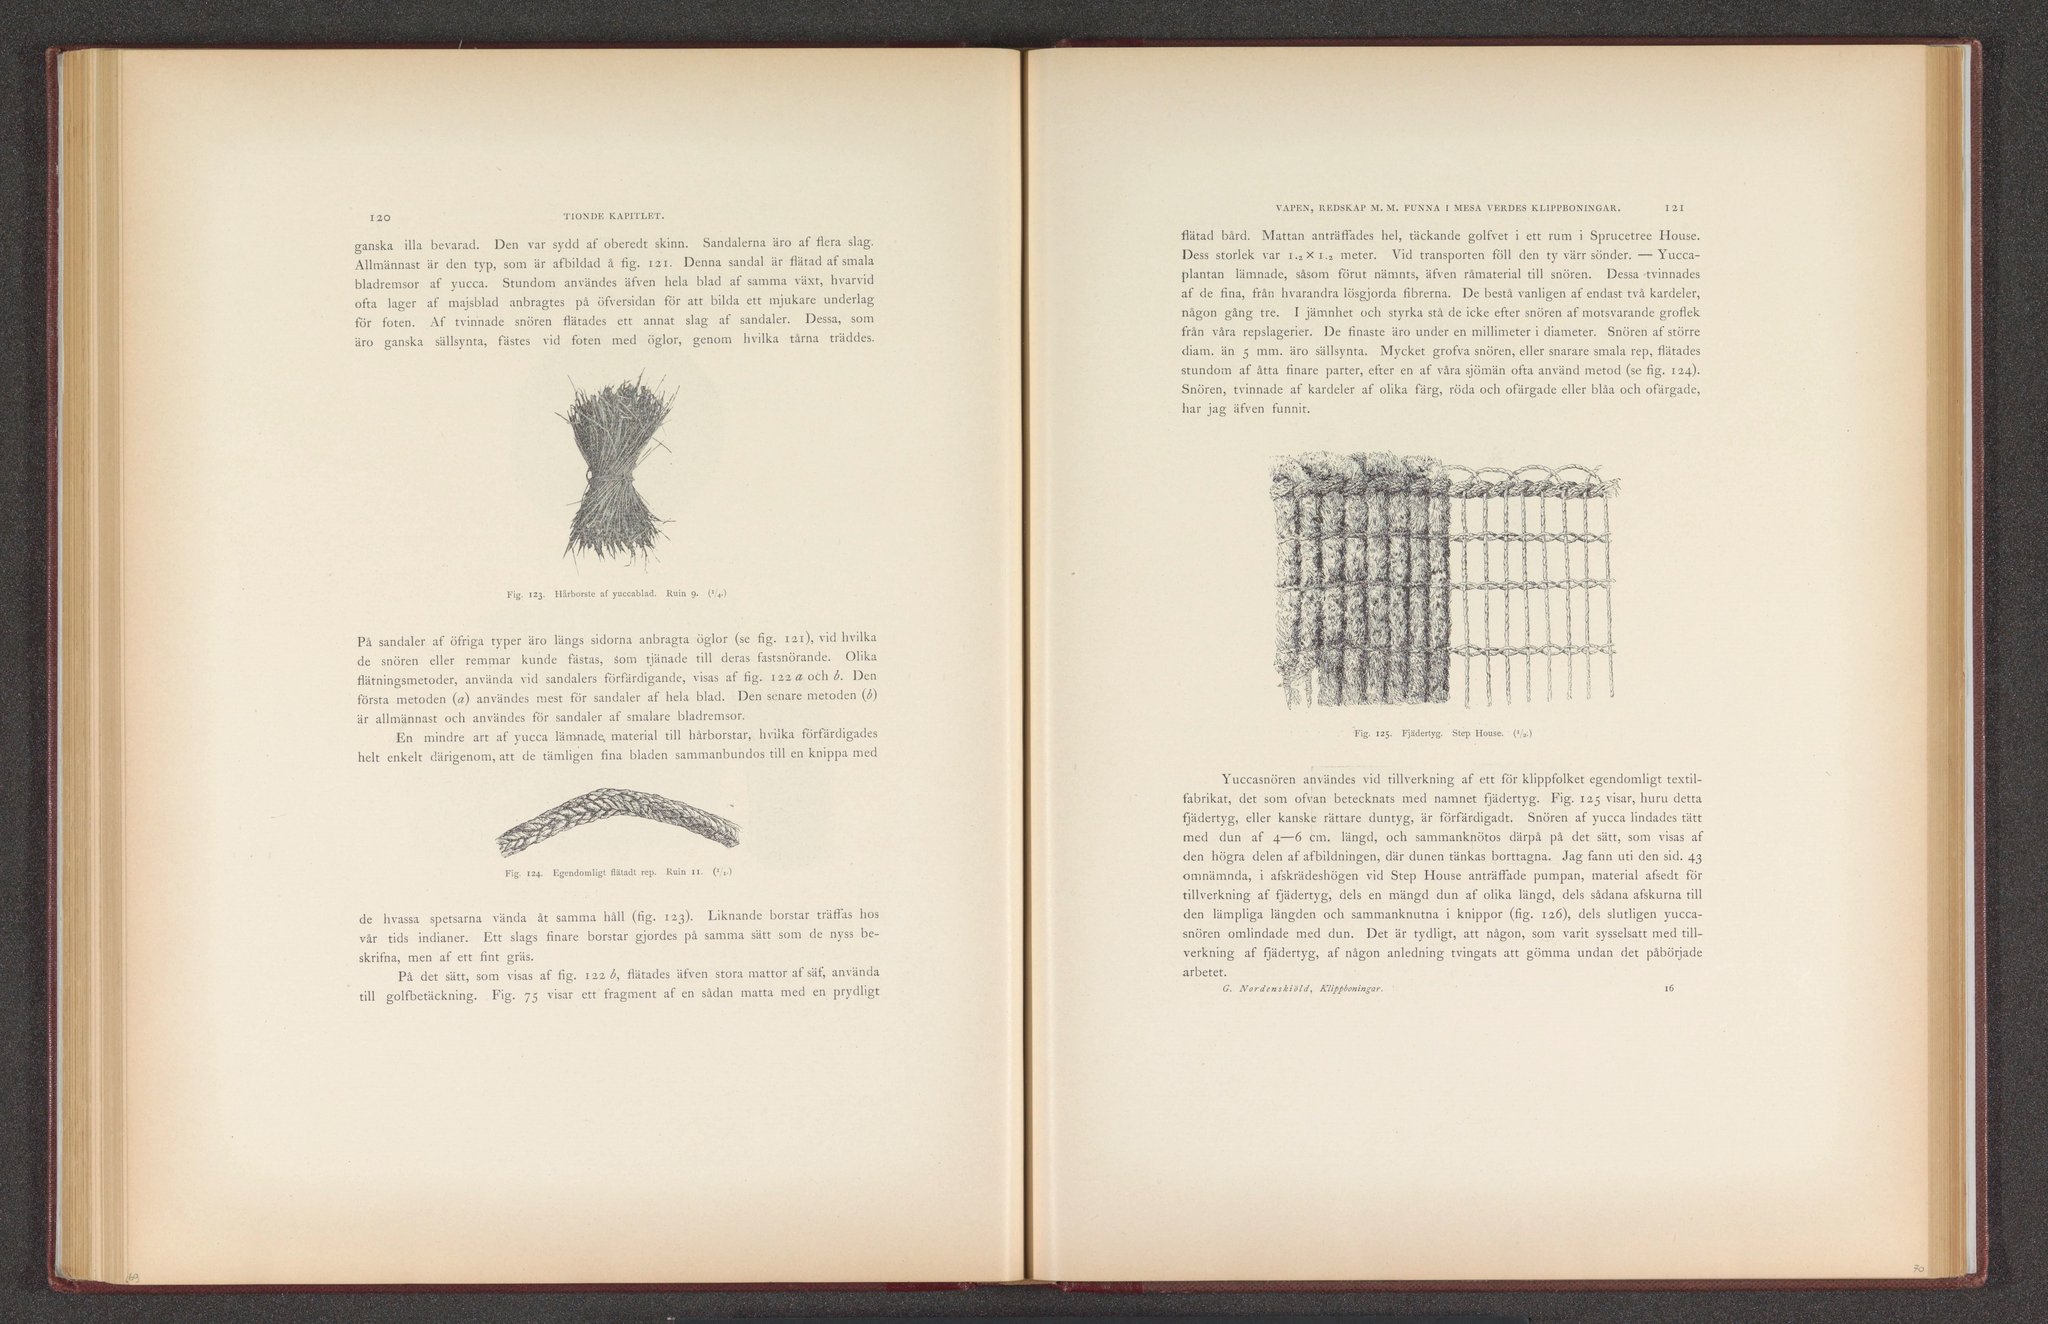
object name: page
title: Borstel of bezem van Yucca bladeren die is gevonden in het Mesa Verde National Park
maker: gustaf nordenskiöld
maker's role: fotograaf, schrijver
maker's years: 1868-1895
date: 1891-1893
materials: paper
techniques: autotype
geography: vienna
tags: shrubs: broom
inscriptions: number: ‘Fig. 123.’